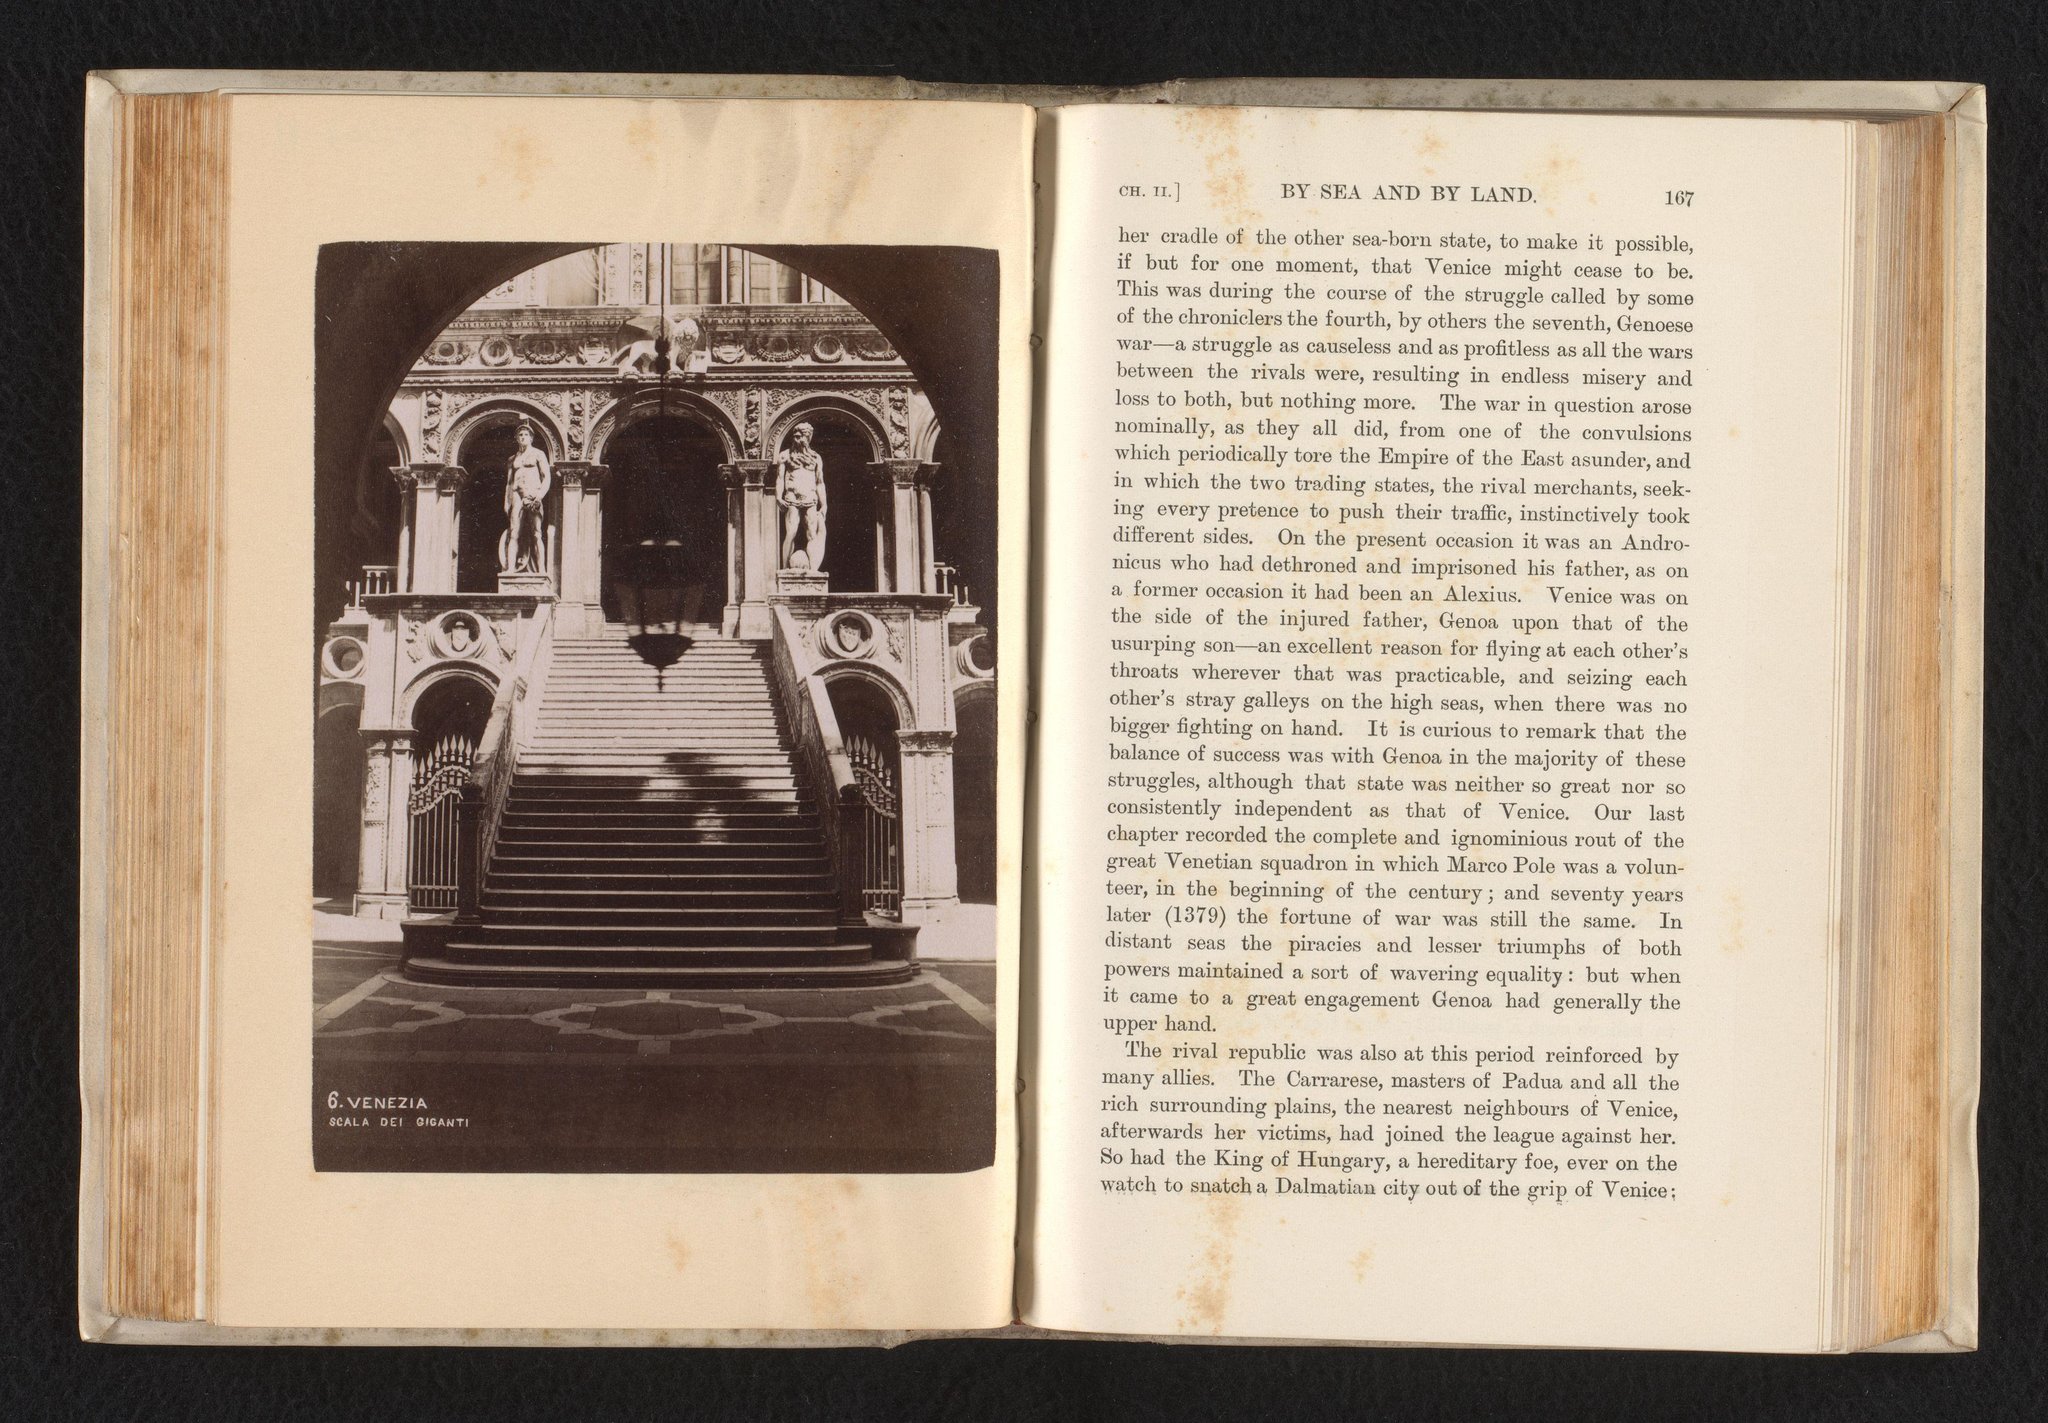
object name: photograph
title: Scala dei Giganti bij het Dogepaleis in Venetië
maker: Anonymous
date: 1888-1893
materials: paper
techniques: albumen print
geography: venice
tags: front steps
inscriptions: number: ‘6.’